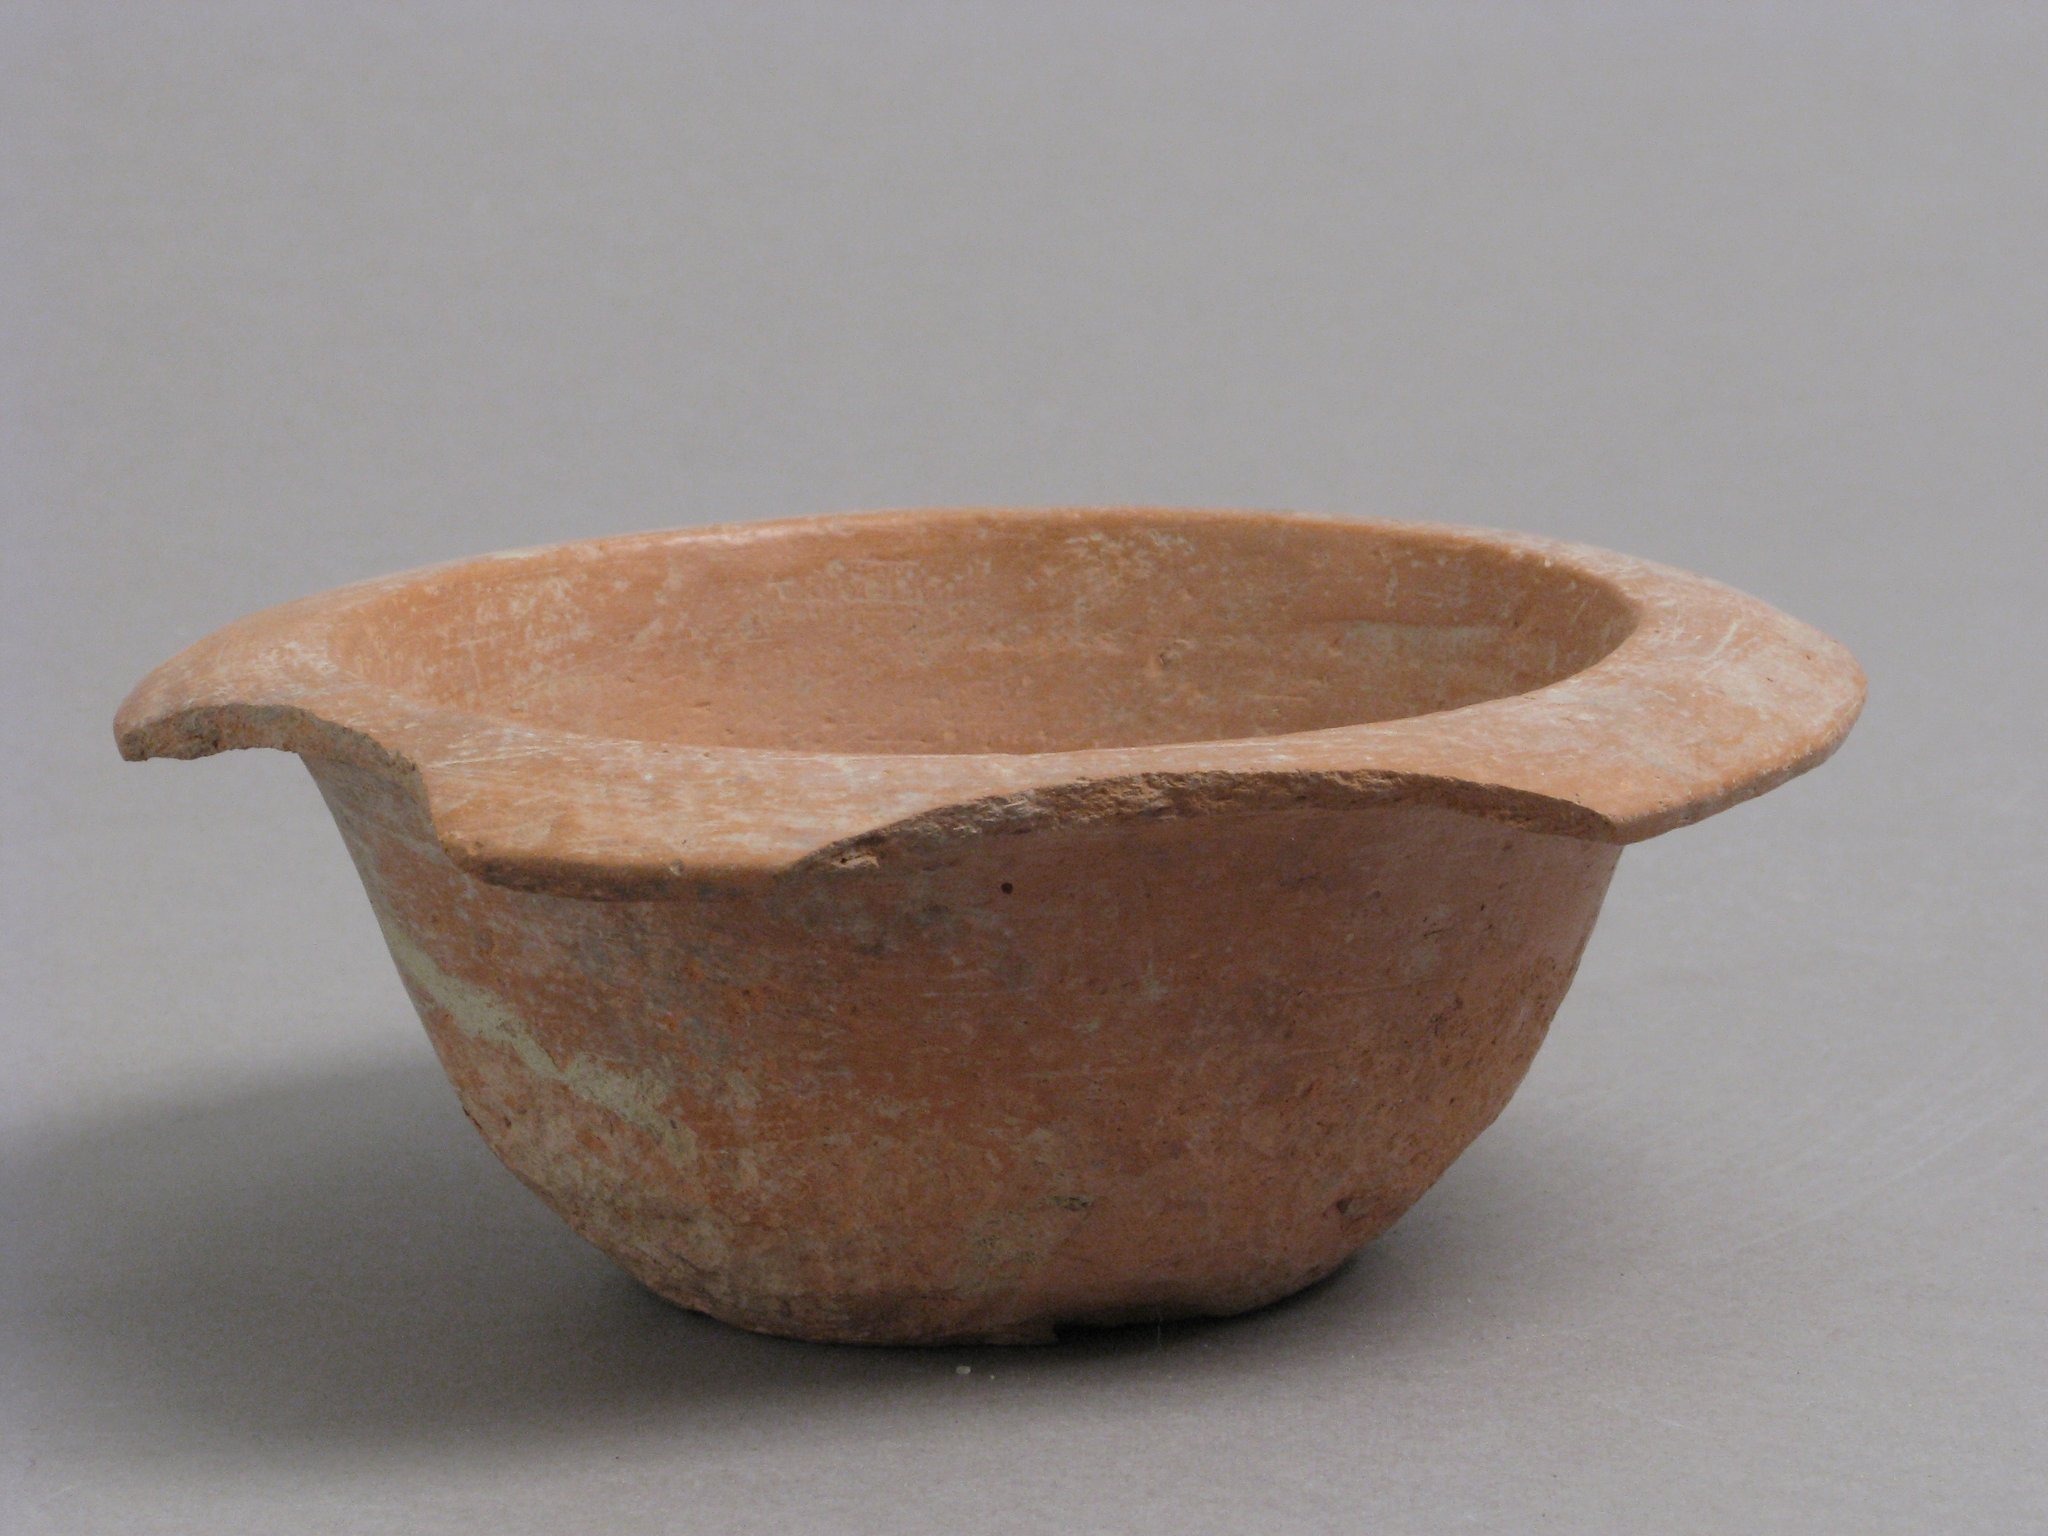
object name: bowl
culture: coptic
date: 301-700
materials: earthenware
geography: egypt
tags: bowls